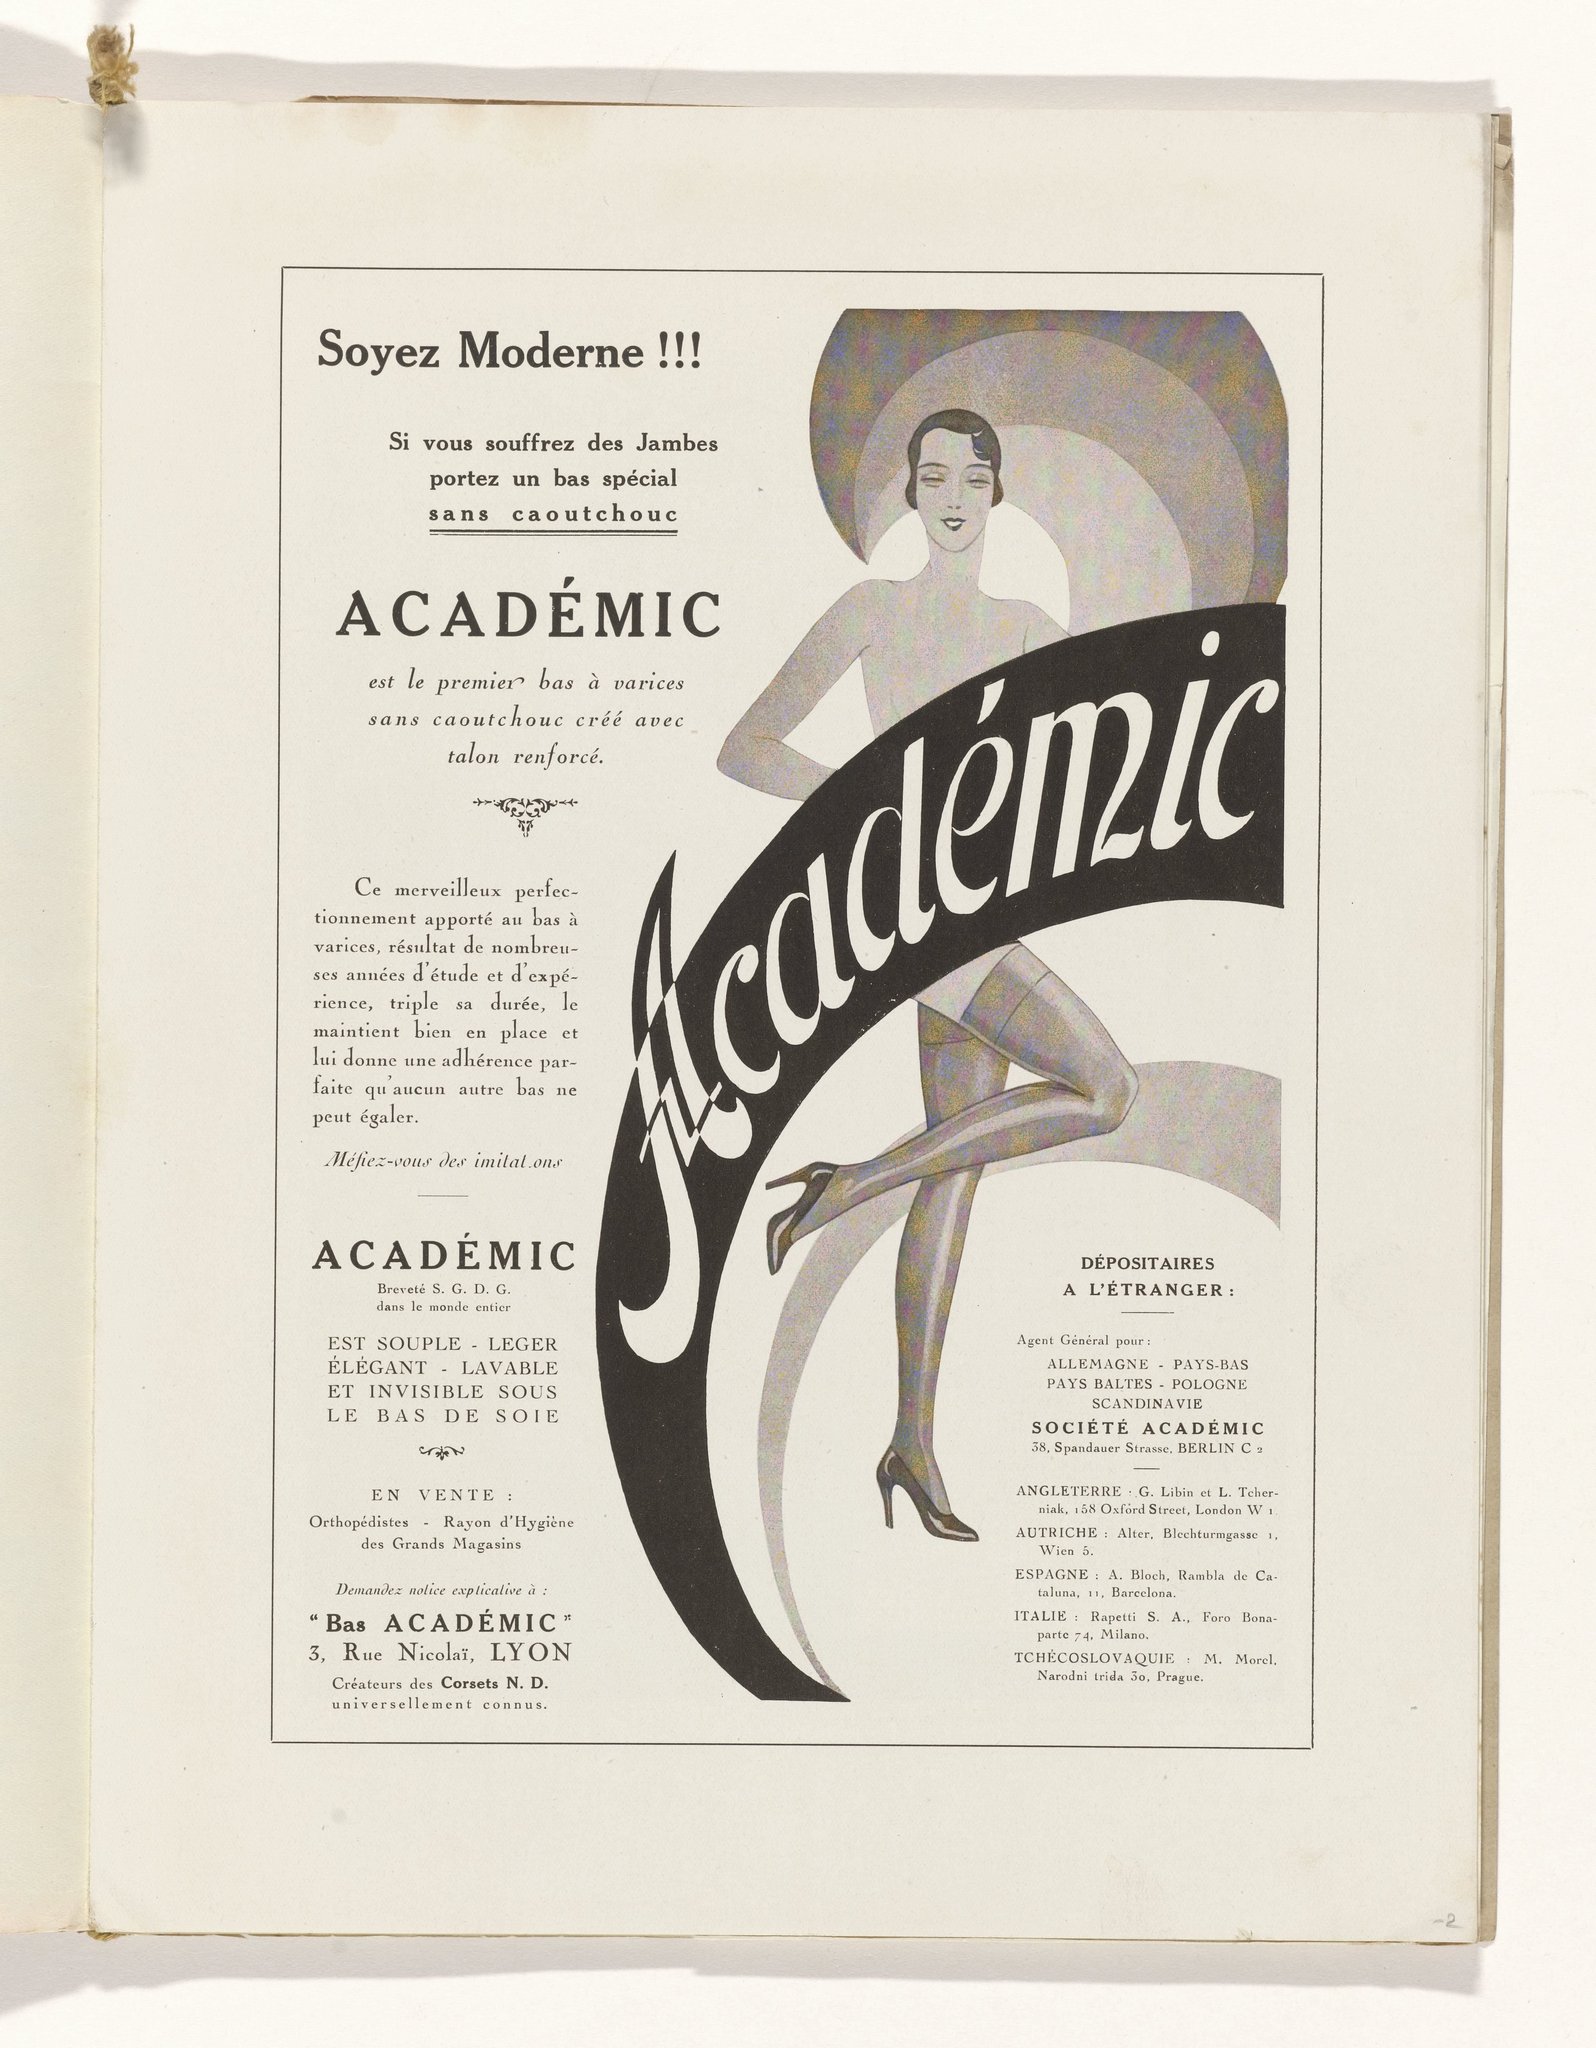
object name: fashion print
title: Art - Goût - Beauté, Feuillets de l' élégance féminine, Juin 1929, No. 106, 9e Année, p.2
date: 1929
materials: paper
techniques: photography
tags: fashion plates, stockings, socks (+ women's clothes)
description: Advertentie voor kousen van Académic. Pagina uit het modetijdschrift Art-Goût-Beauté (1920-1933).